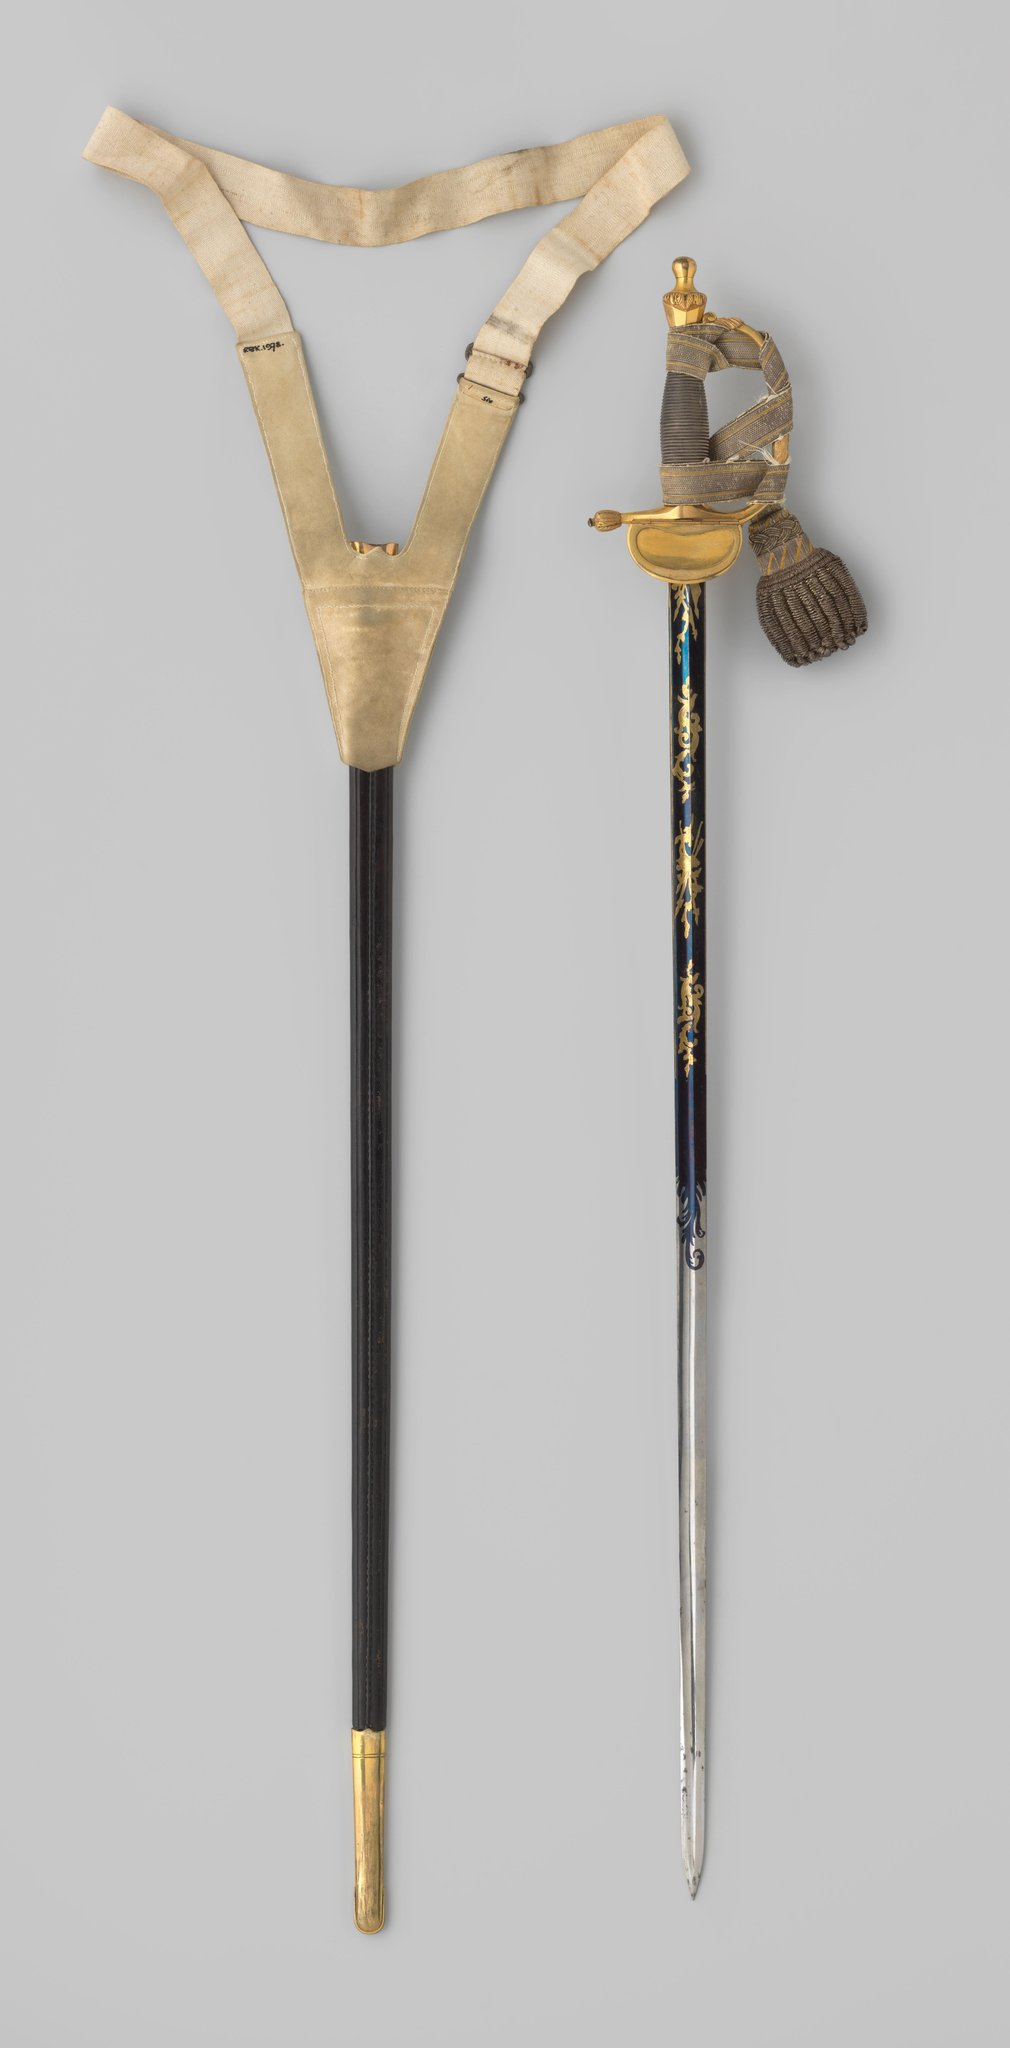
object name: sword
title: Officiersdegen, met zilveren dragon, zwart leren schede, wit leren koppel en een foedraal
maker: peter knecht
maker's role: weapon manufacturer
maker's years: 1798-1852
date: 1825-1850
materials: leather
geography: solingen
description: Officiersdegen (a), met zilveren dragon (b), zwart leren schede (c), wit leren koppel (d) en een foedraal (e).